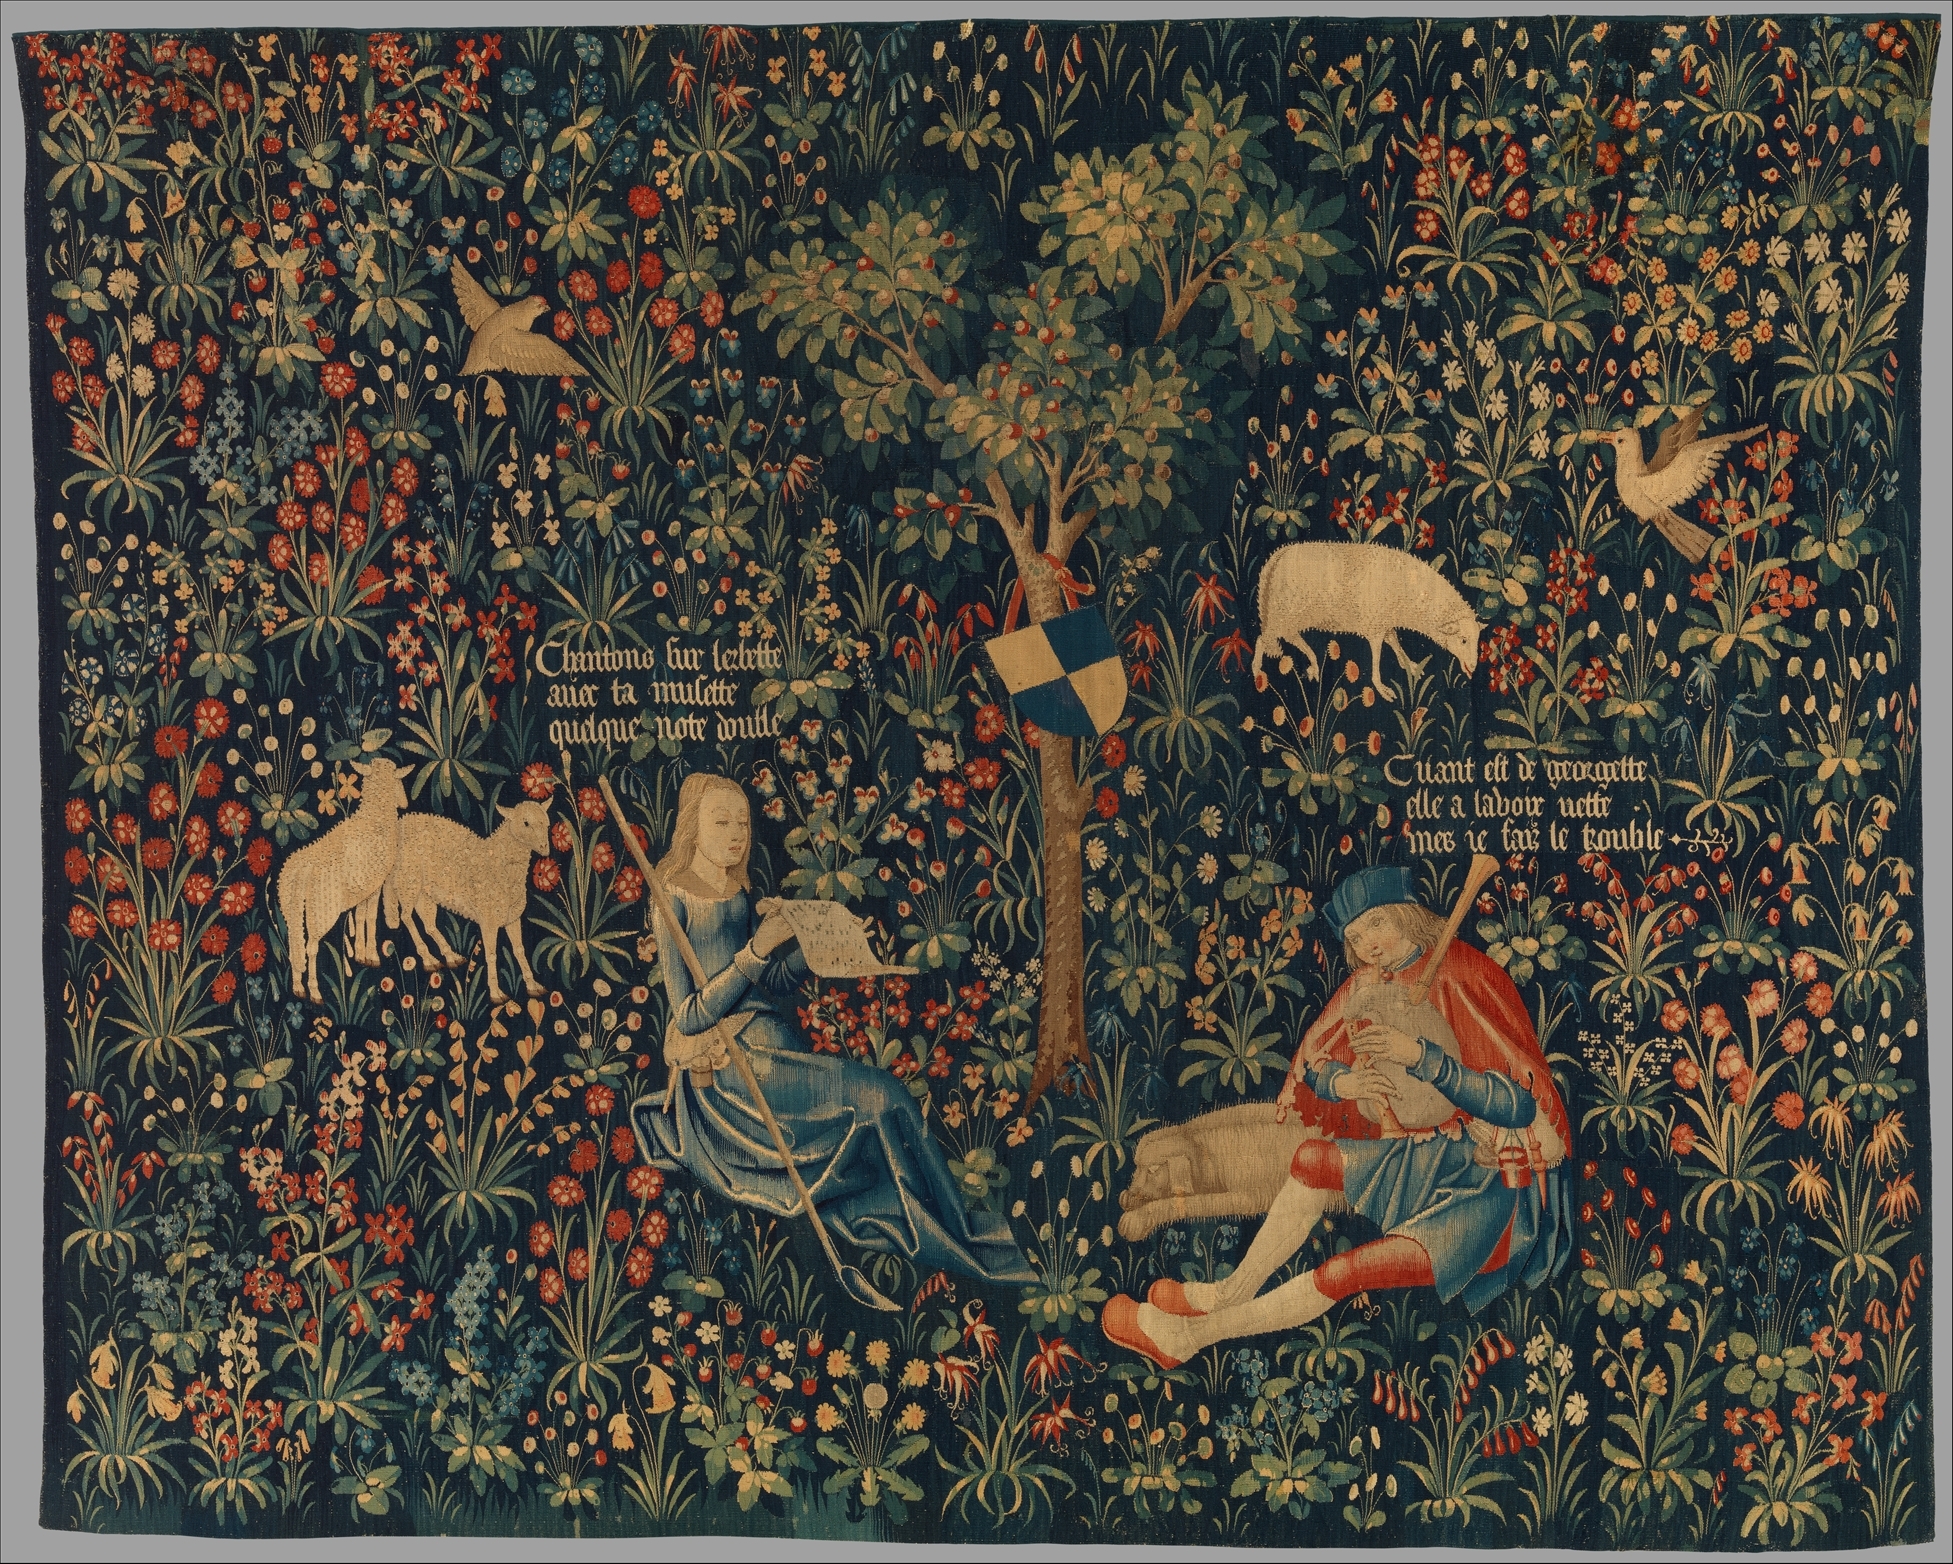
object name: tapestry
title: Shepherd and Shepherdess Making Music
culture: south netherlandish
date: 1500-1530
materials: silk, wool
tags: men,women,music,bagpipes,sheep,shepherds